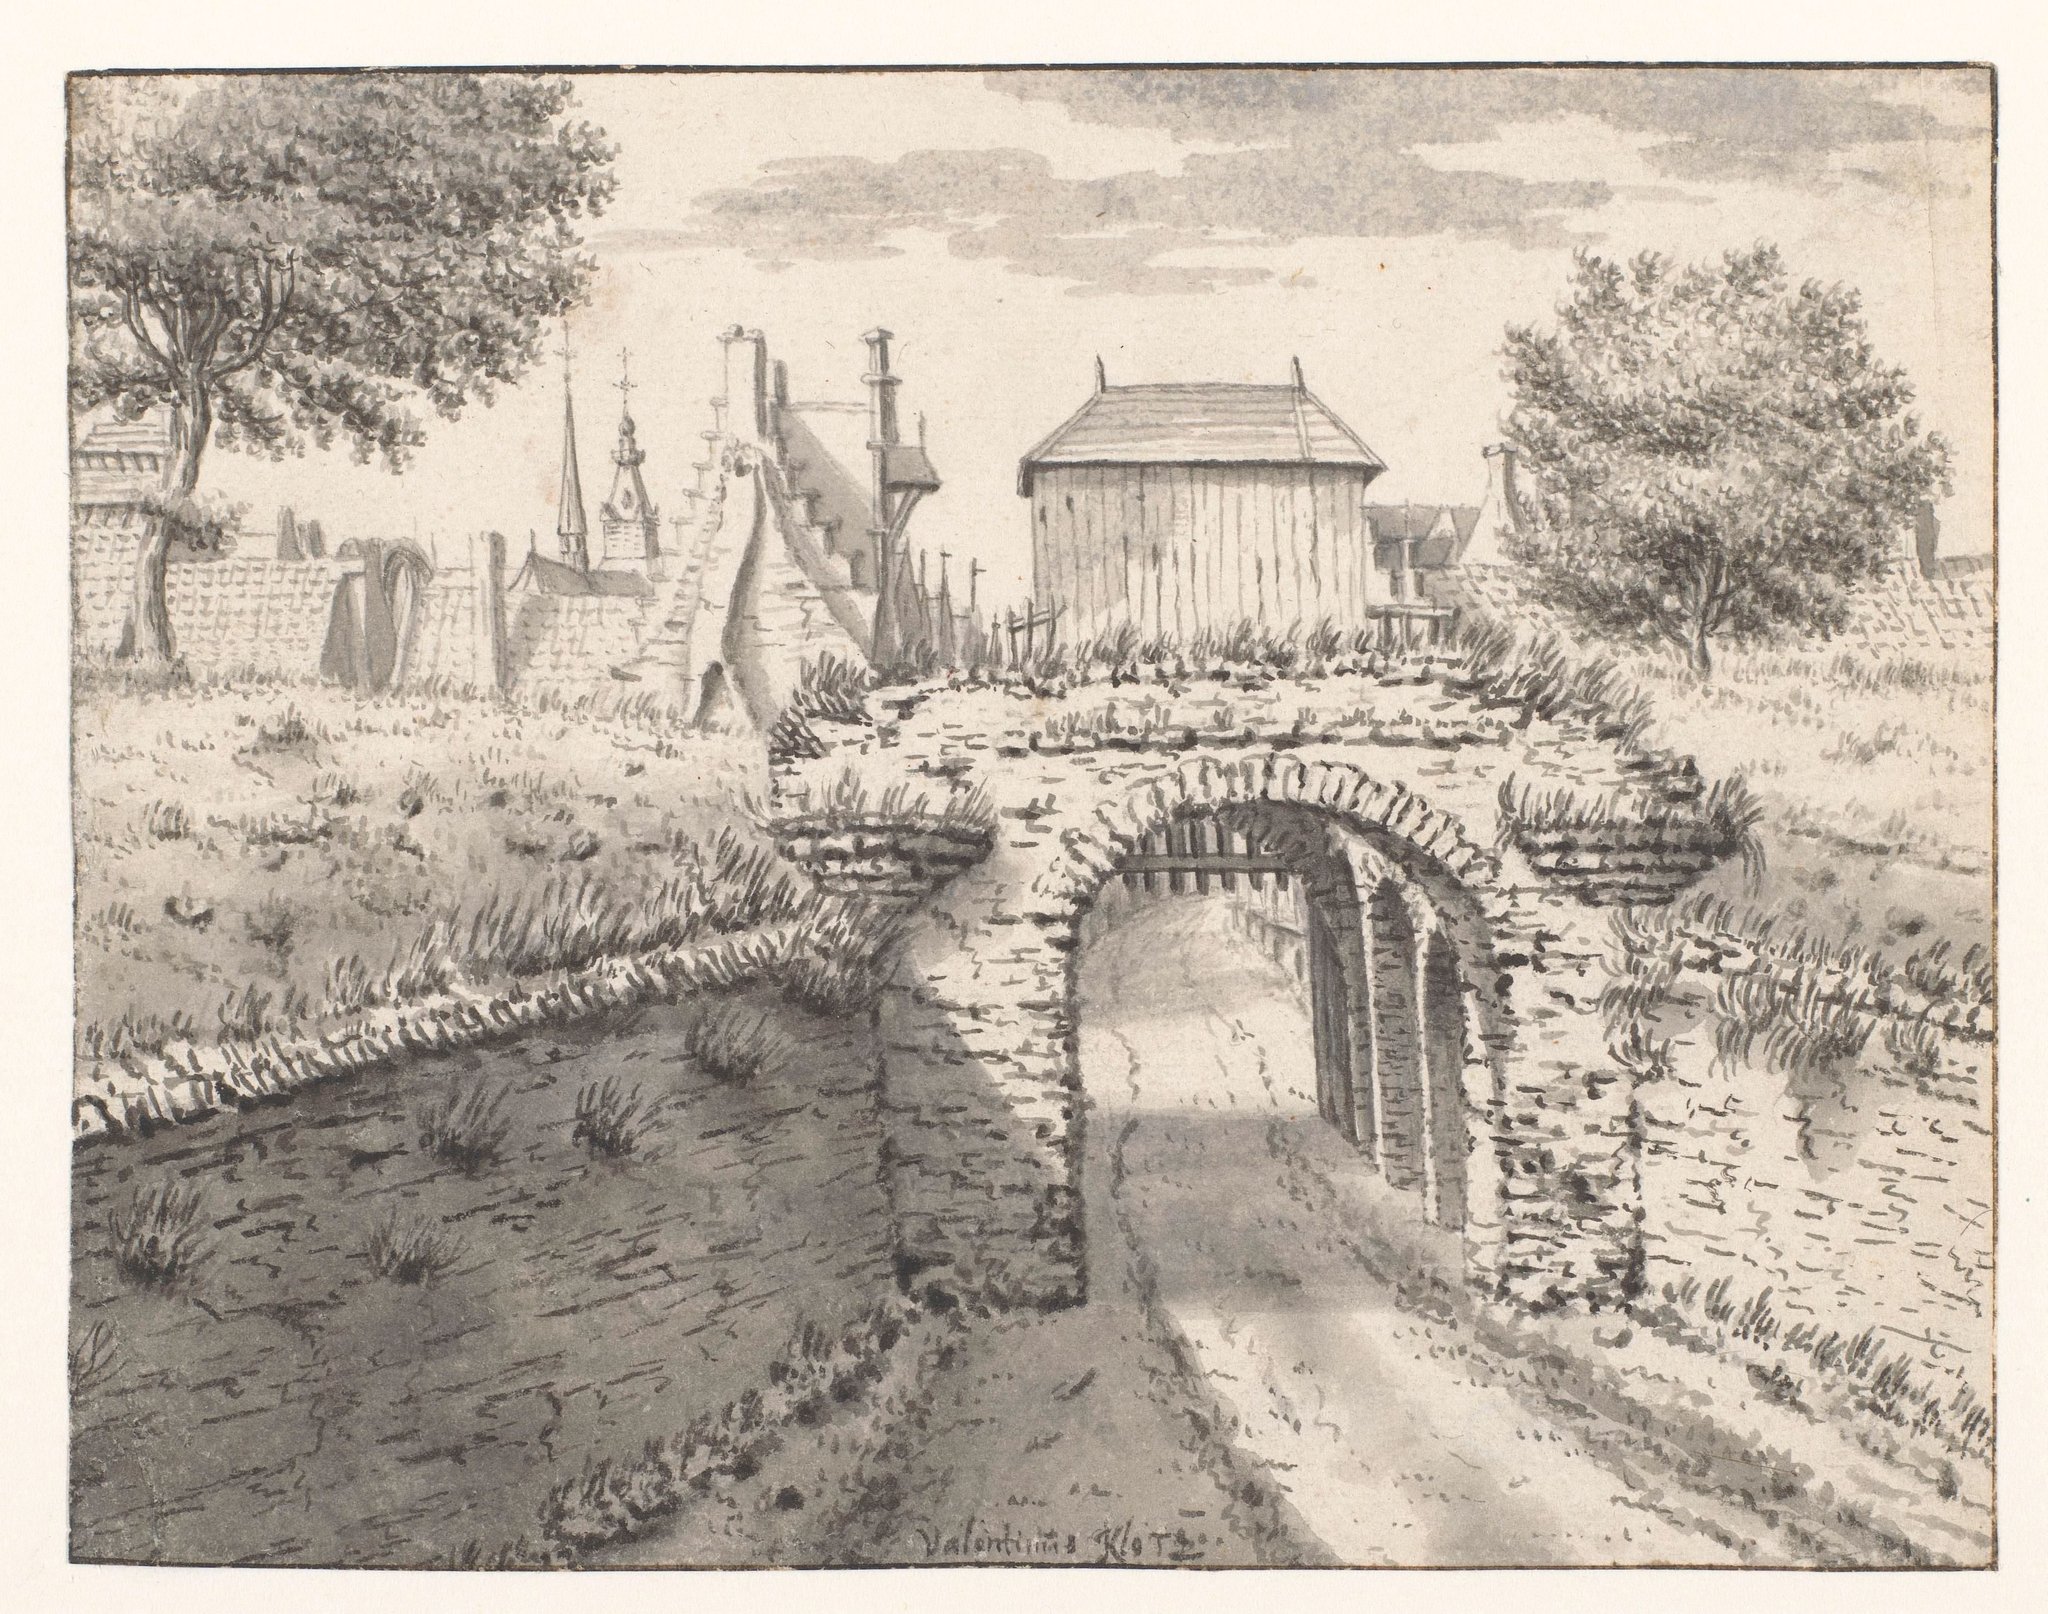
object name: drawing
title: View of the Wouwsepoort at Bergen op Zoom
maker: valentijn klotz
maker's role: draughtsman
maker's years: 1646-1721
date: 1671-1672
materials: ink, paper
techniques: brush, pen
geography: bergen op zoom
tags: city-gate, bergen op zoom